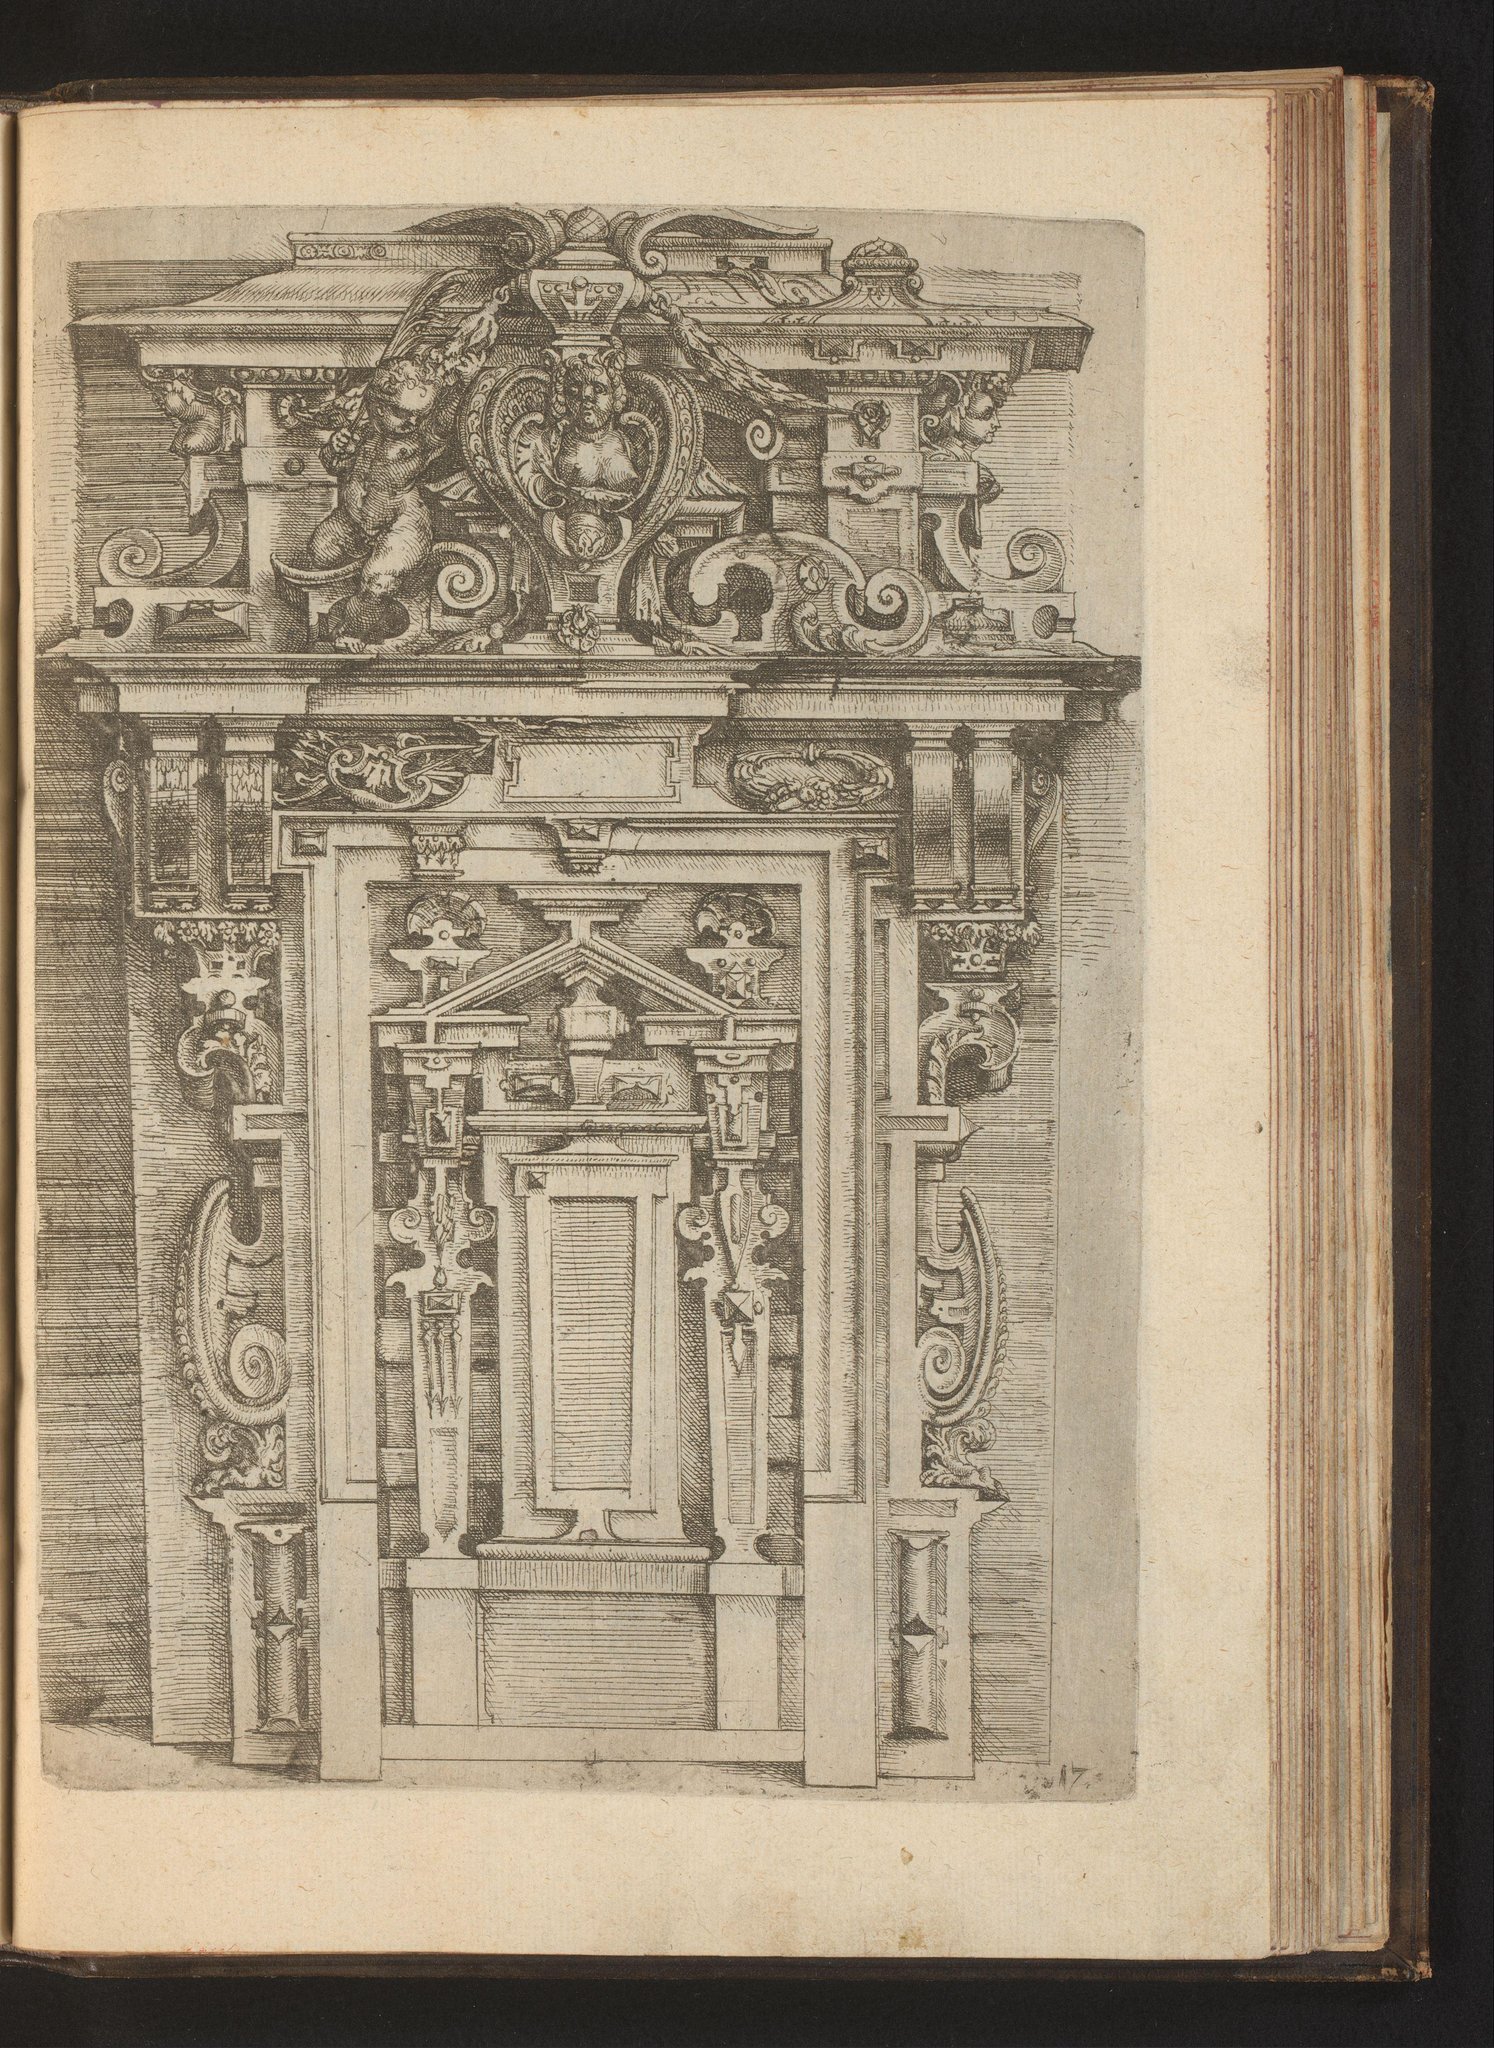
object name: book illustration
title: Architectura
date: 1593-1595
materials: paper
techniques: etching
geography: straatsburg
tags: parts of church exterior and annexes: portal, doric order ~ architecture, 'laub- und bandelwerk' ~ ornament, ornament derived from architectural details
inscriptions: collector's mark: Lugt 2228, collector's mark: Lugt 2760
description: Prent gebruikt in: Dietterlin, Wendel (I). Wendel Dietterlin, Architectura de Polstium seu Portalium ornatu uario Liber II. Straatsburg: Bernhard Jobin, 1594.